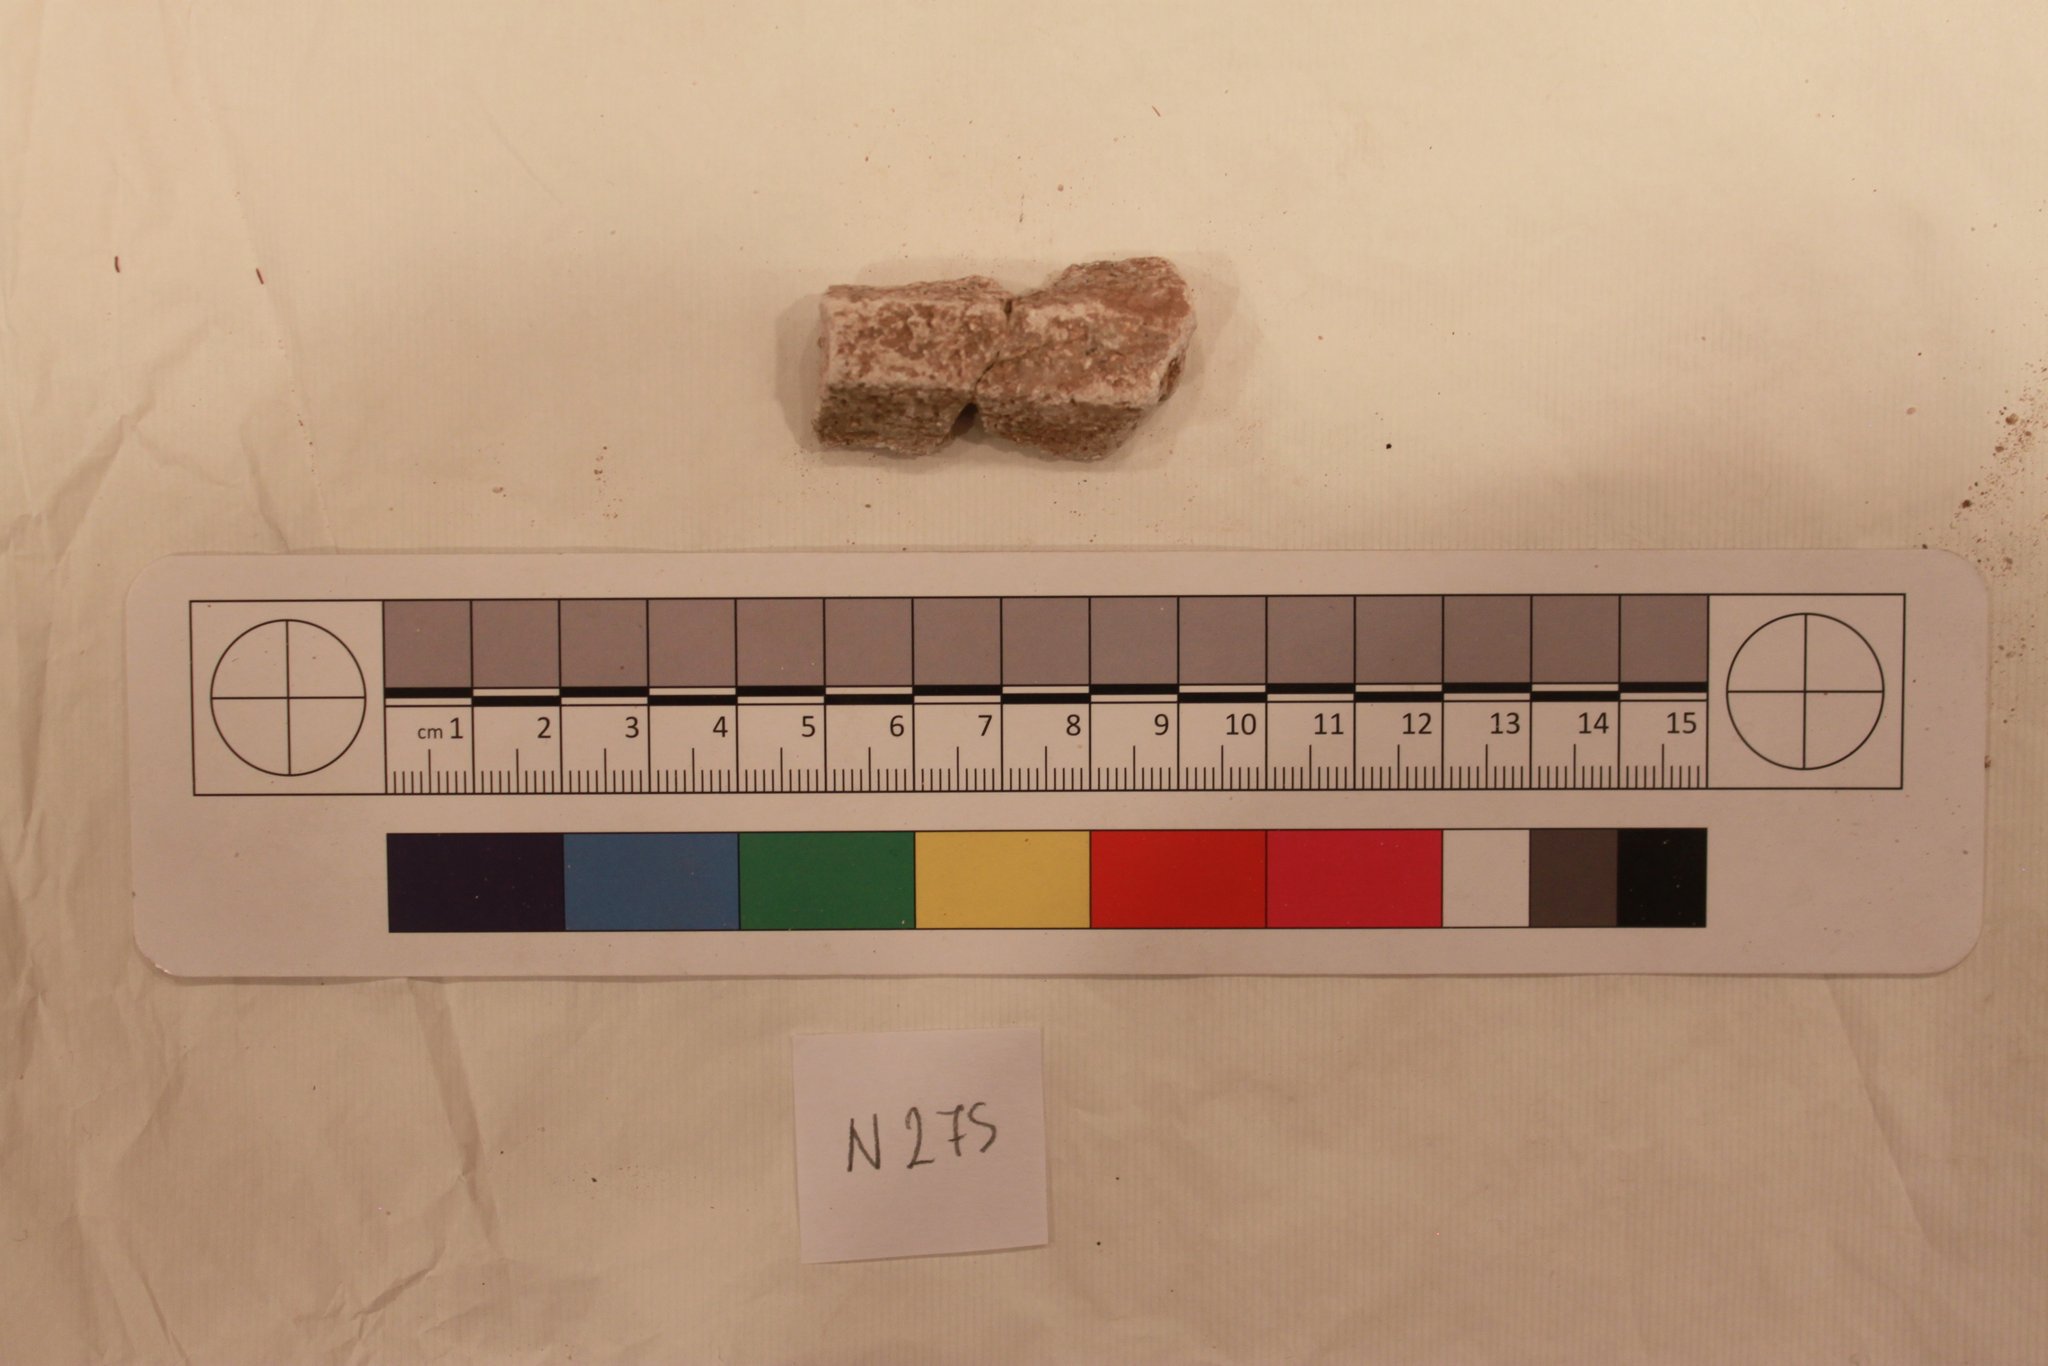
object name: fragment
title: Stucco Fragment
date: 701-1200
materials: plaster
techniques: carving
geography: iran